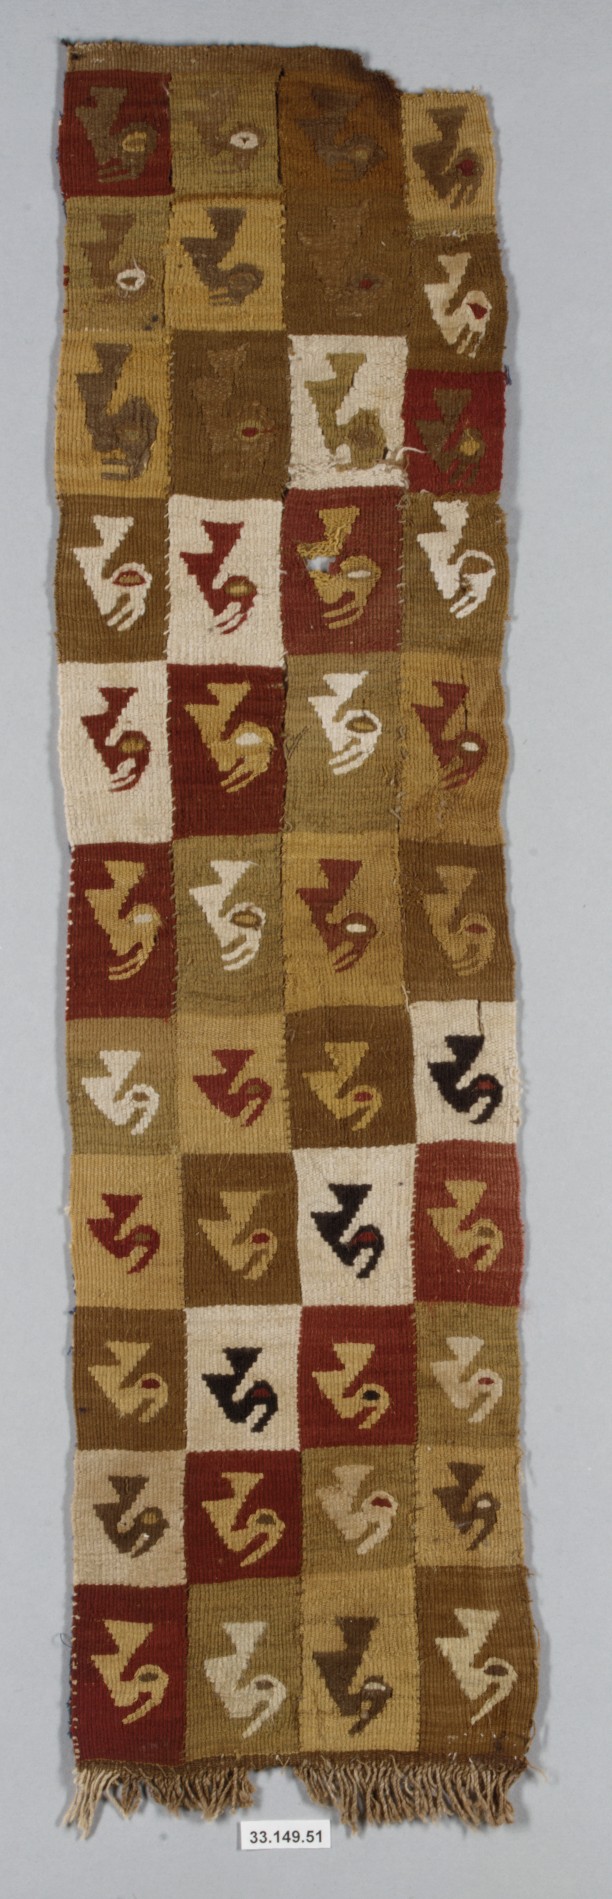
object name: textile fragment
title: Tapestry Fragment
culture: peruvian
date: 901-1500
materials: animal fiber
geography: peru